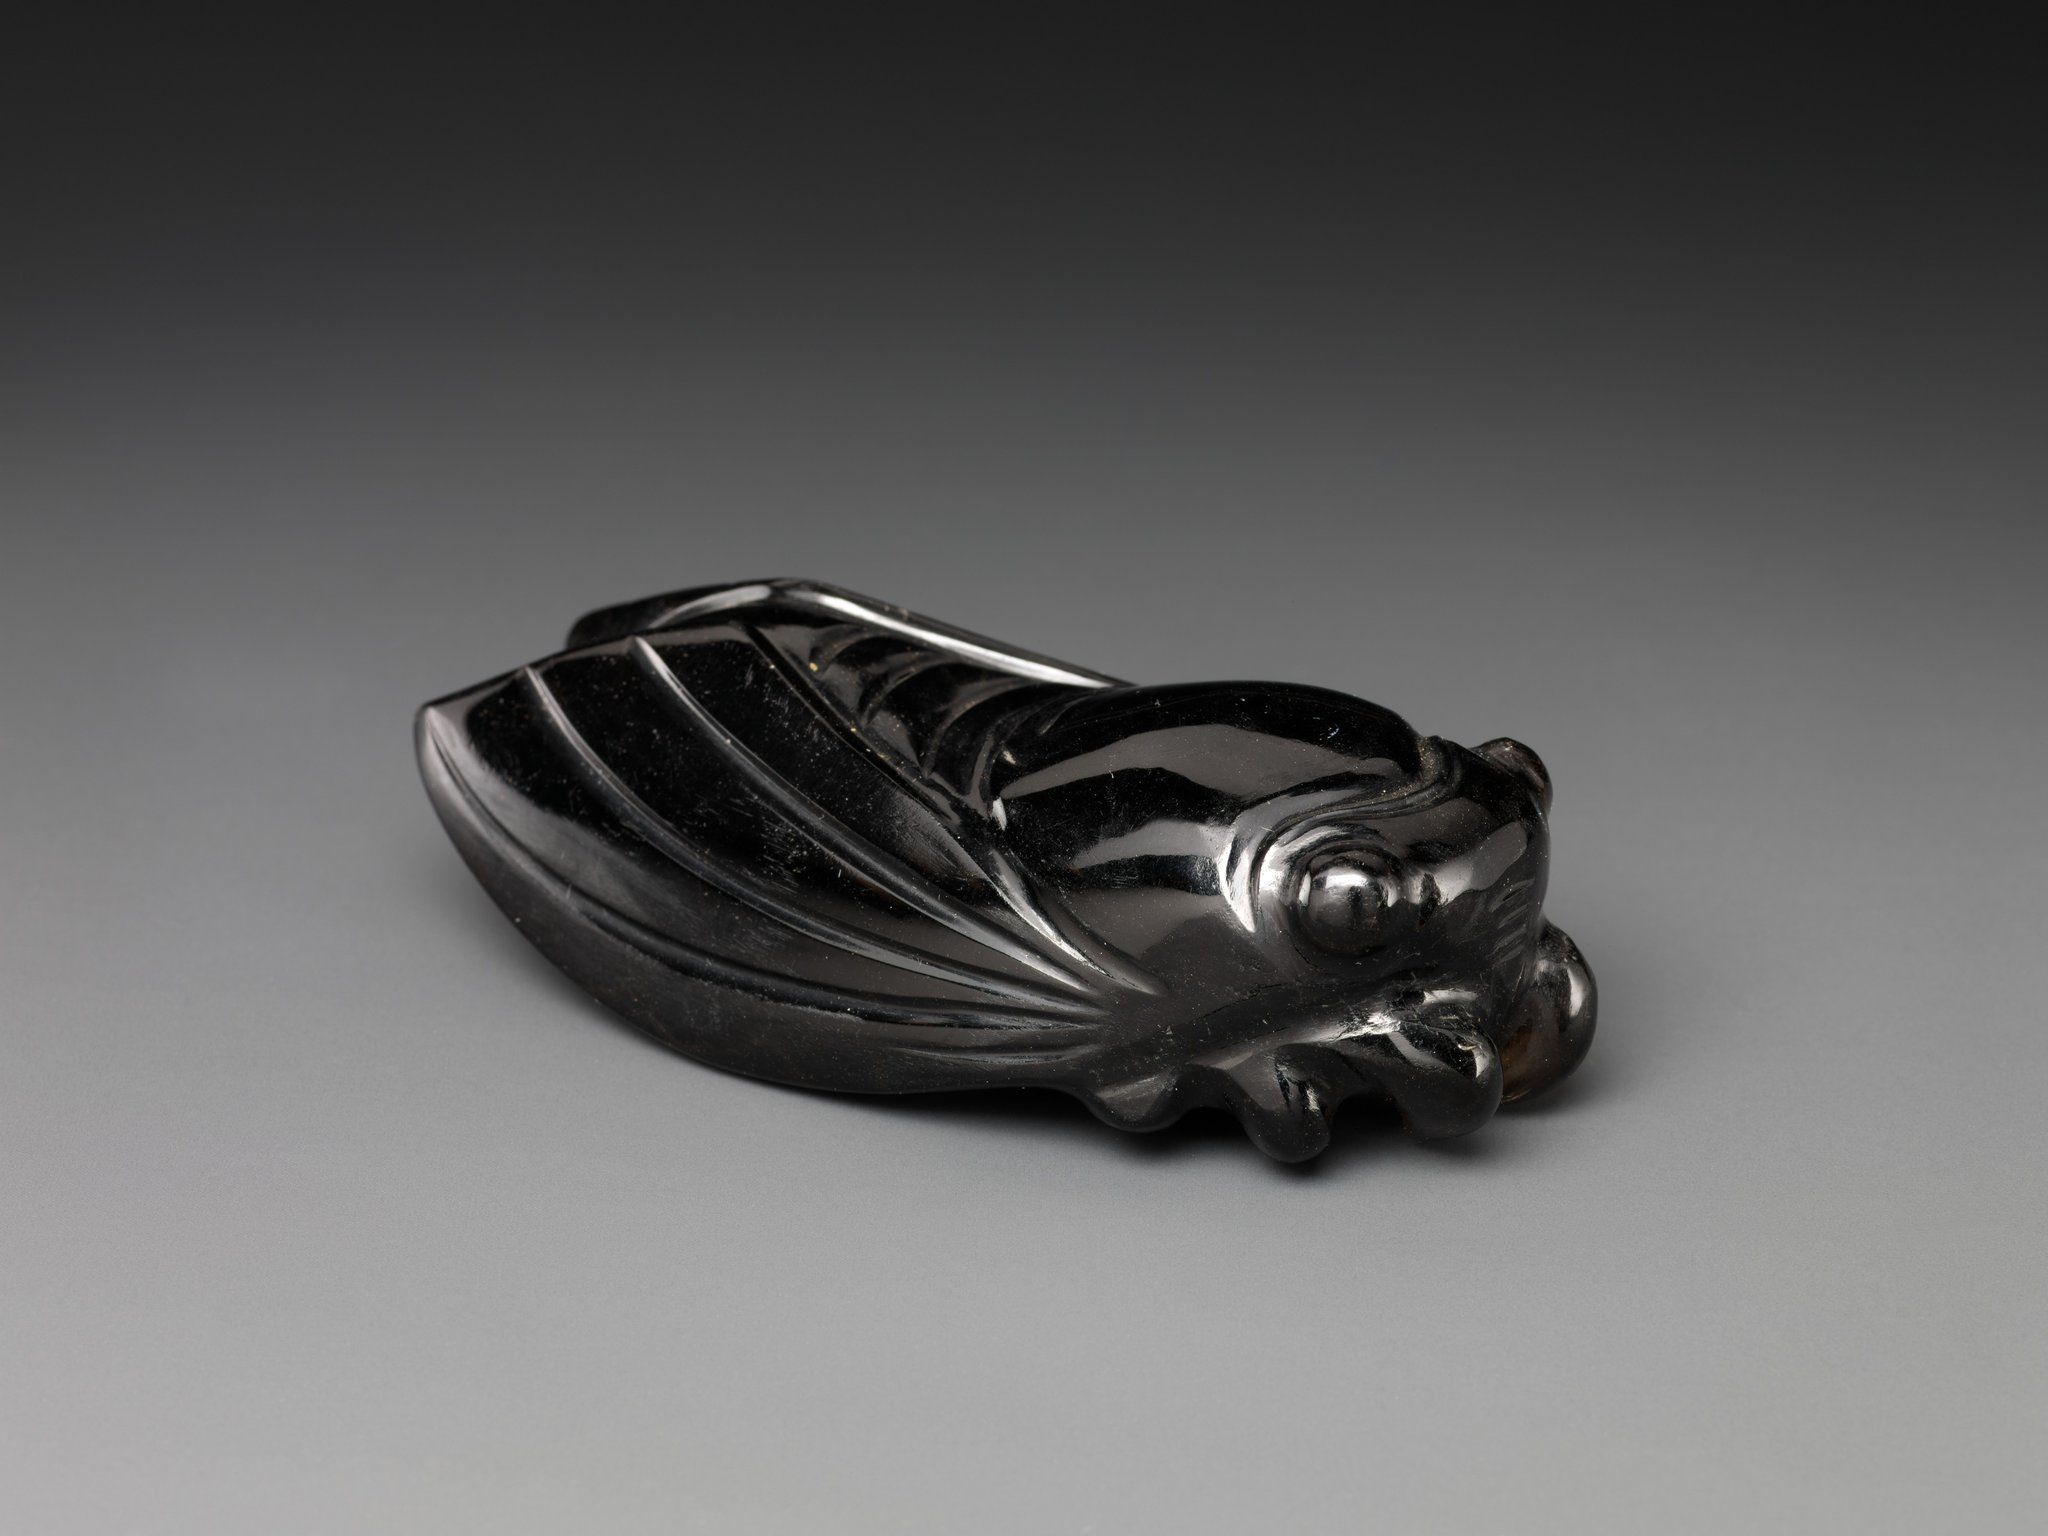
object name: figure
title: Figure of a cicada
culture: chinese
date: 1767-1833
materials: quartz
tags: insects